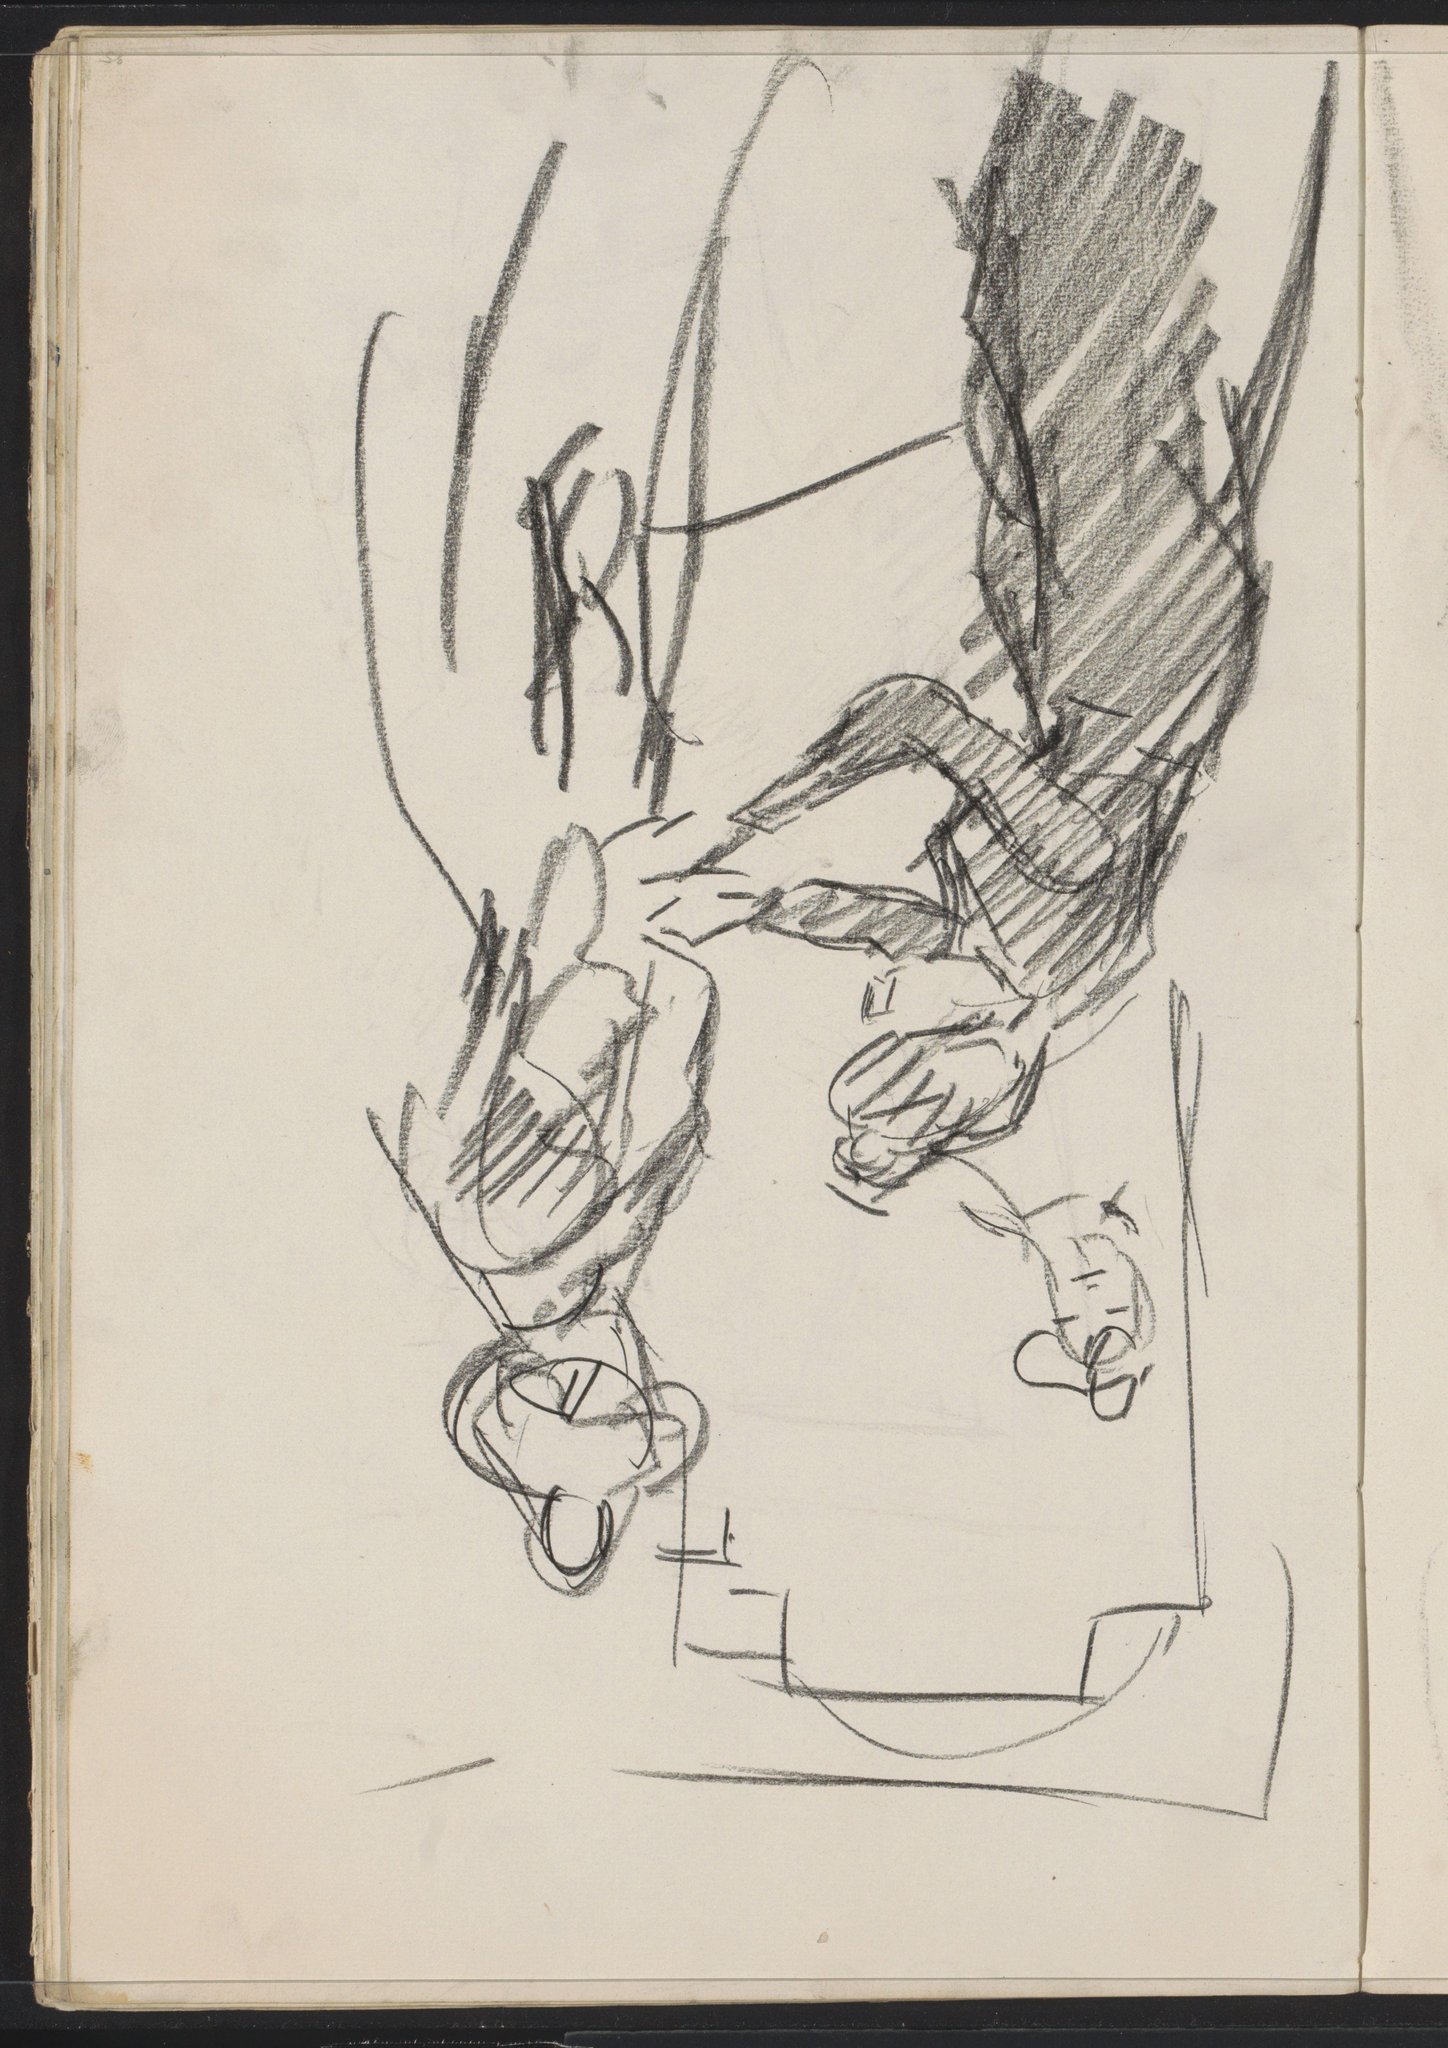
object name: sketchbook leaf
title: Vrouw bij een naaister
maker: isaac israels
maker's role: draughtsman, painter, print maker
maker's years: 1865-1934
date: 1875-1934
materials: chalk, paper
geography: the hague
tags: adult woman (+ standing), sewing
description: De naaister is bezig met de jurk van de andere vrouw. Blad 16 verso uit schetsboek LXIX met 25 bladen.